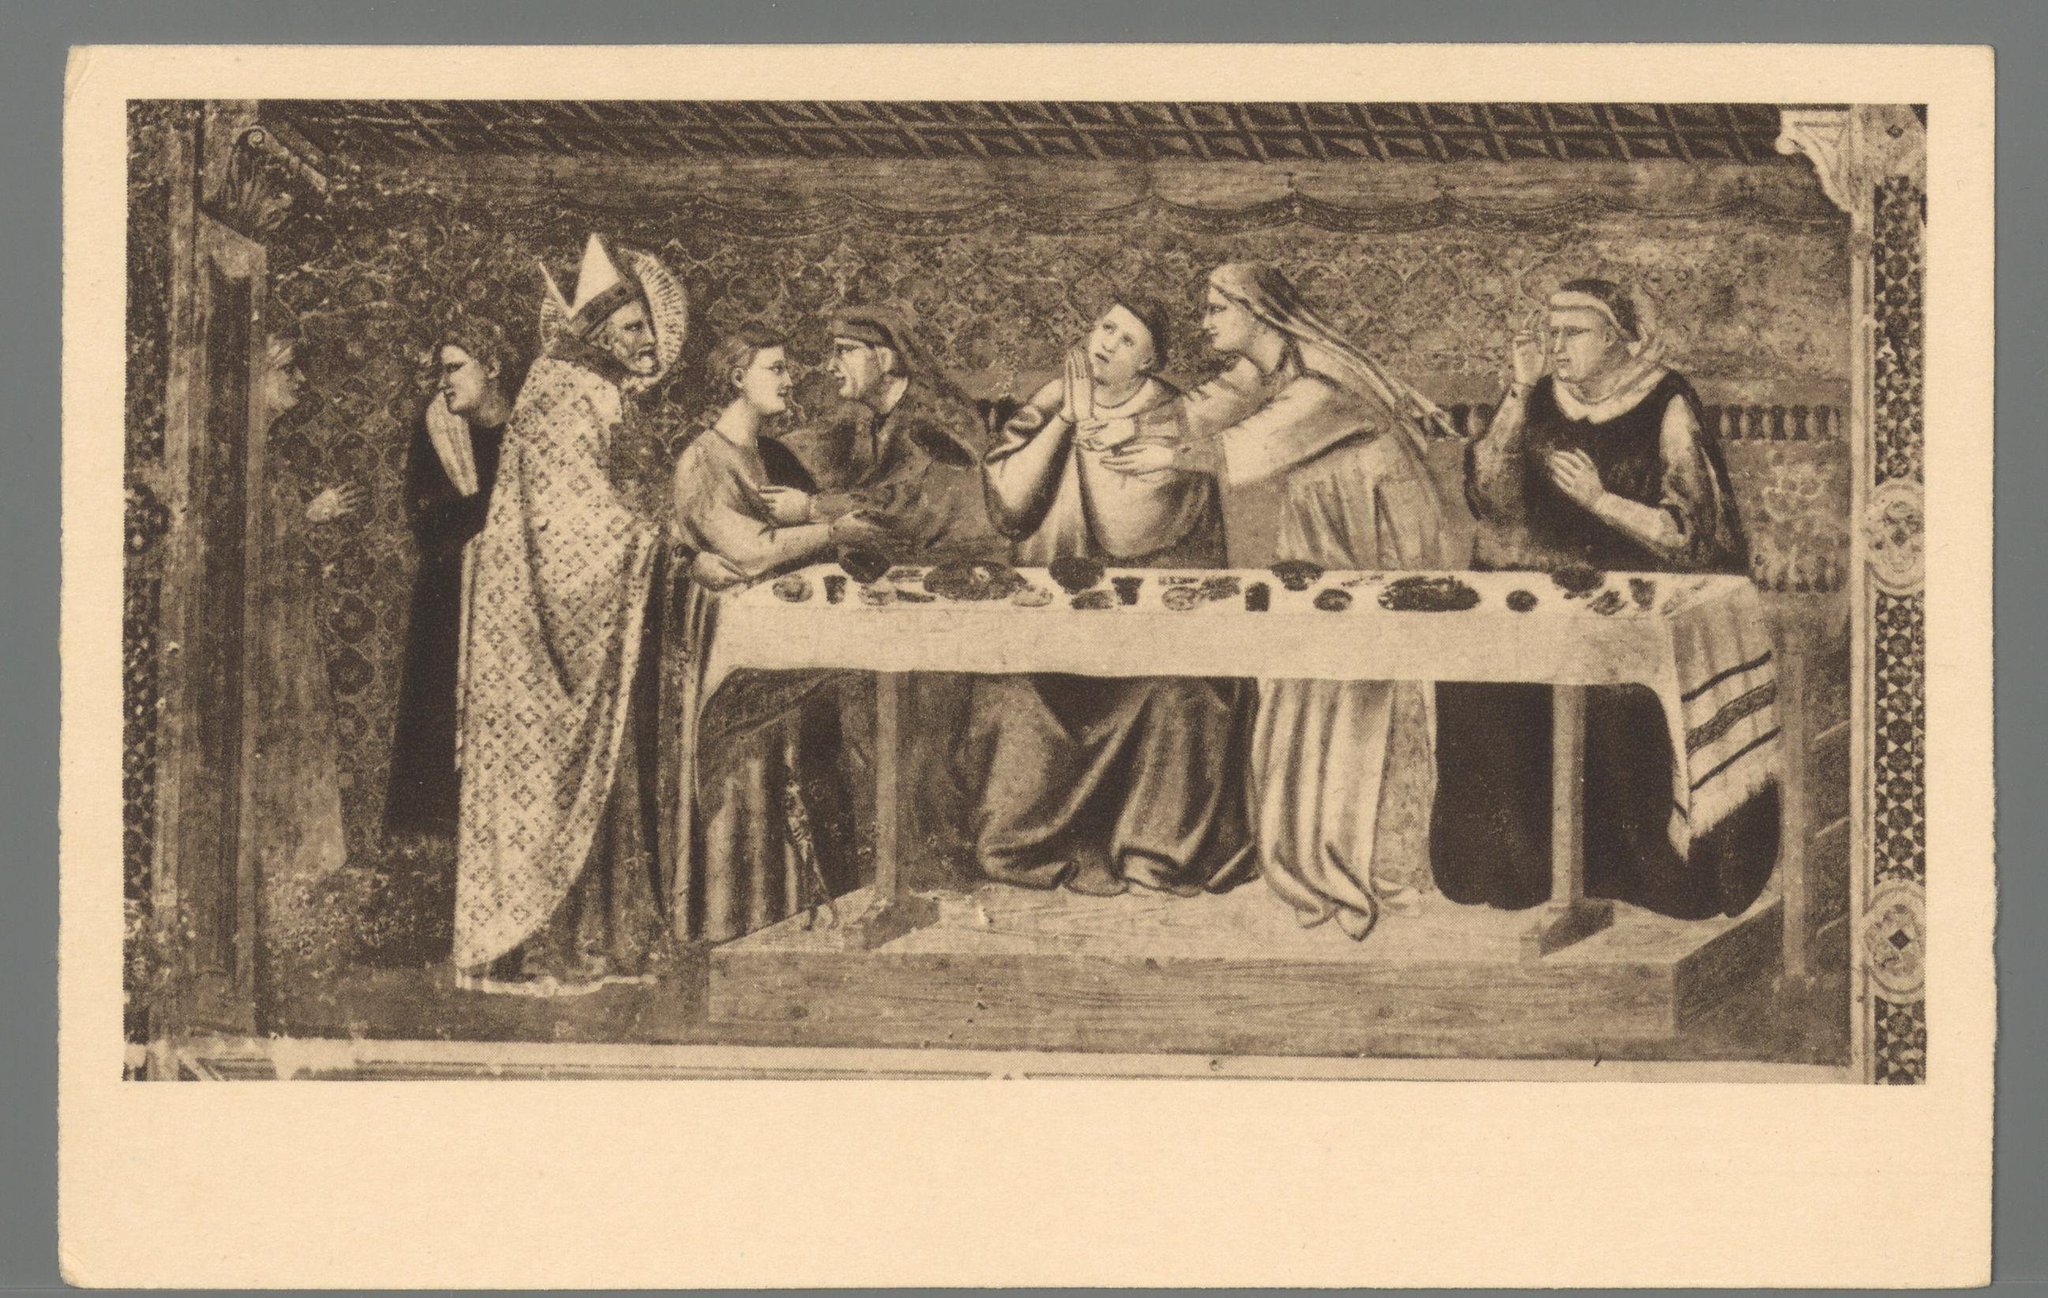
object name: ansichtkaart, prentbriefkaart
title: Giottino (c. 1324-?). De H. Nicolaas plaatst den ontvoerden knaap voor zijn ouders - Assisi, onderkerk van den H. Franciscus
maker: Anonymous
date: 1928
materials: cardboard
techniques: rotogravure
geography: assisi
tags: interior of church, picture, painting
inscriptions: collector's mark: ‘AFE v S’